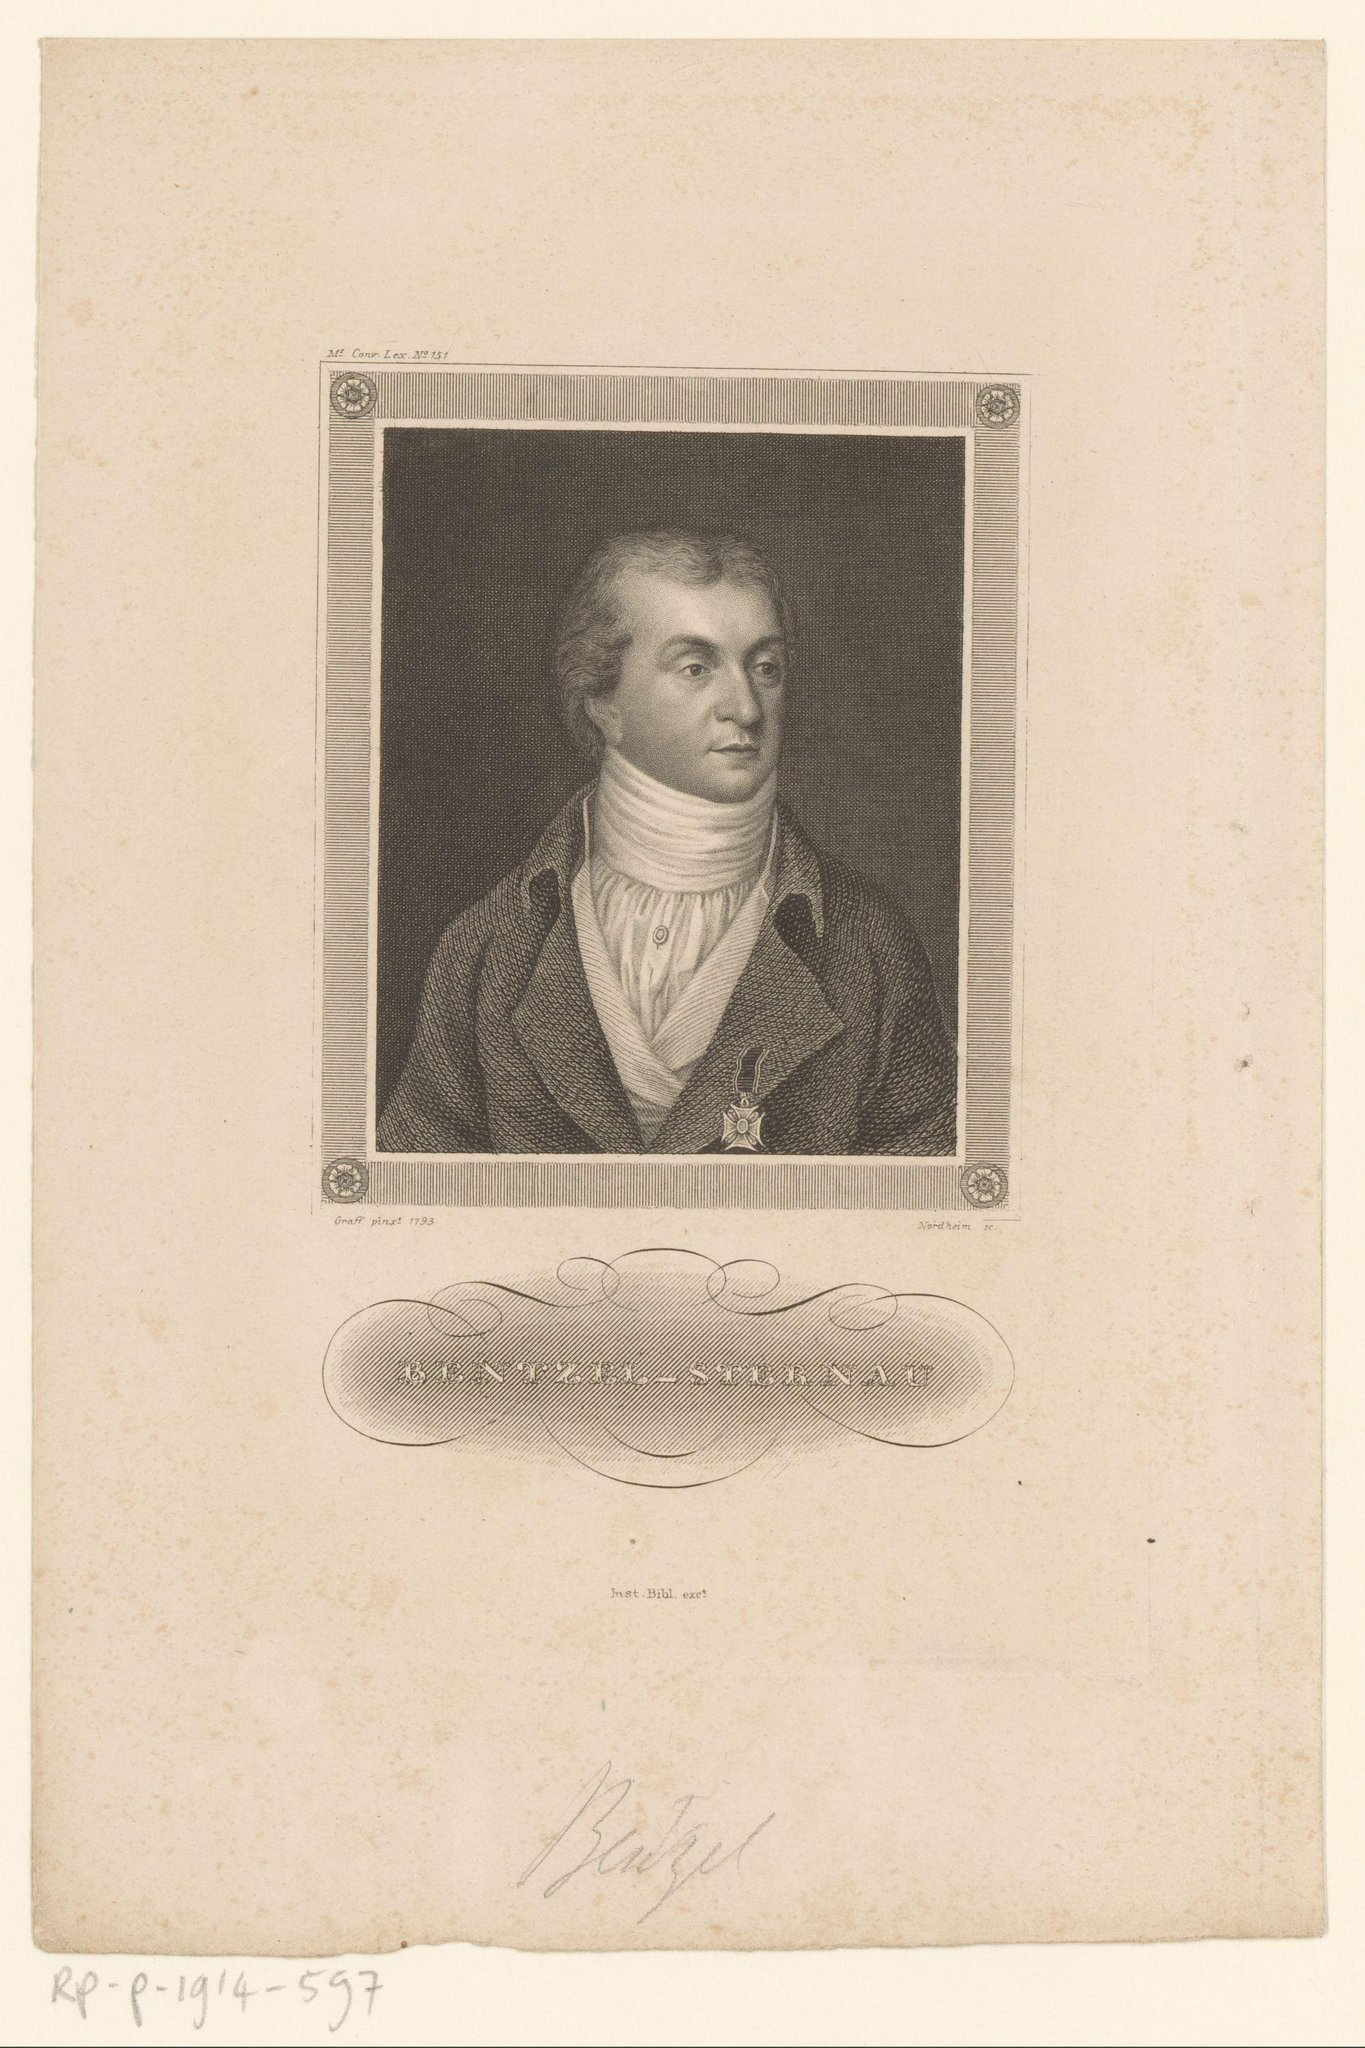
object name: print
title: Portret van Anselm Franz, Freiherr von Bentzel-Sternau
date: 1840-1855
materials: paper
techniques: etching, engraving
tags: historical persons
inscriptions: collector's mark: Lugt 2228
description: Prent afkomstig uit: Conversations-Lexikon für die gebildeten Stände, voor het eerst uitgegeven tussen 1840-1855.